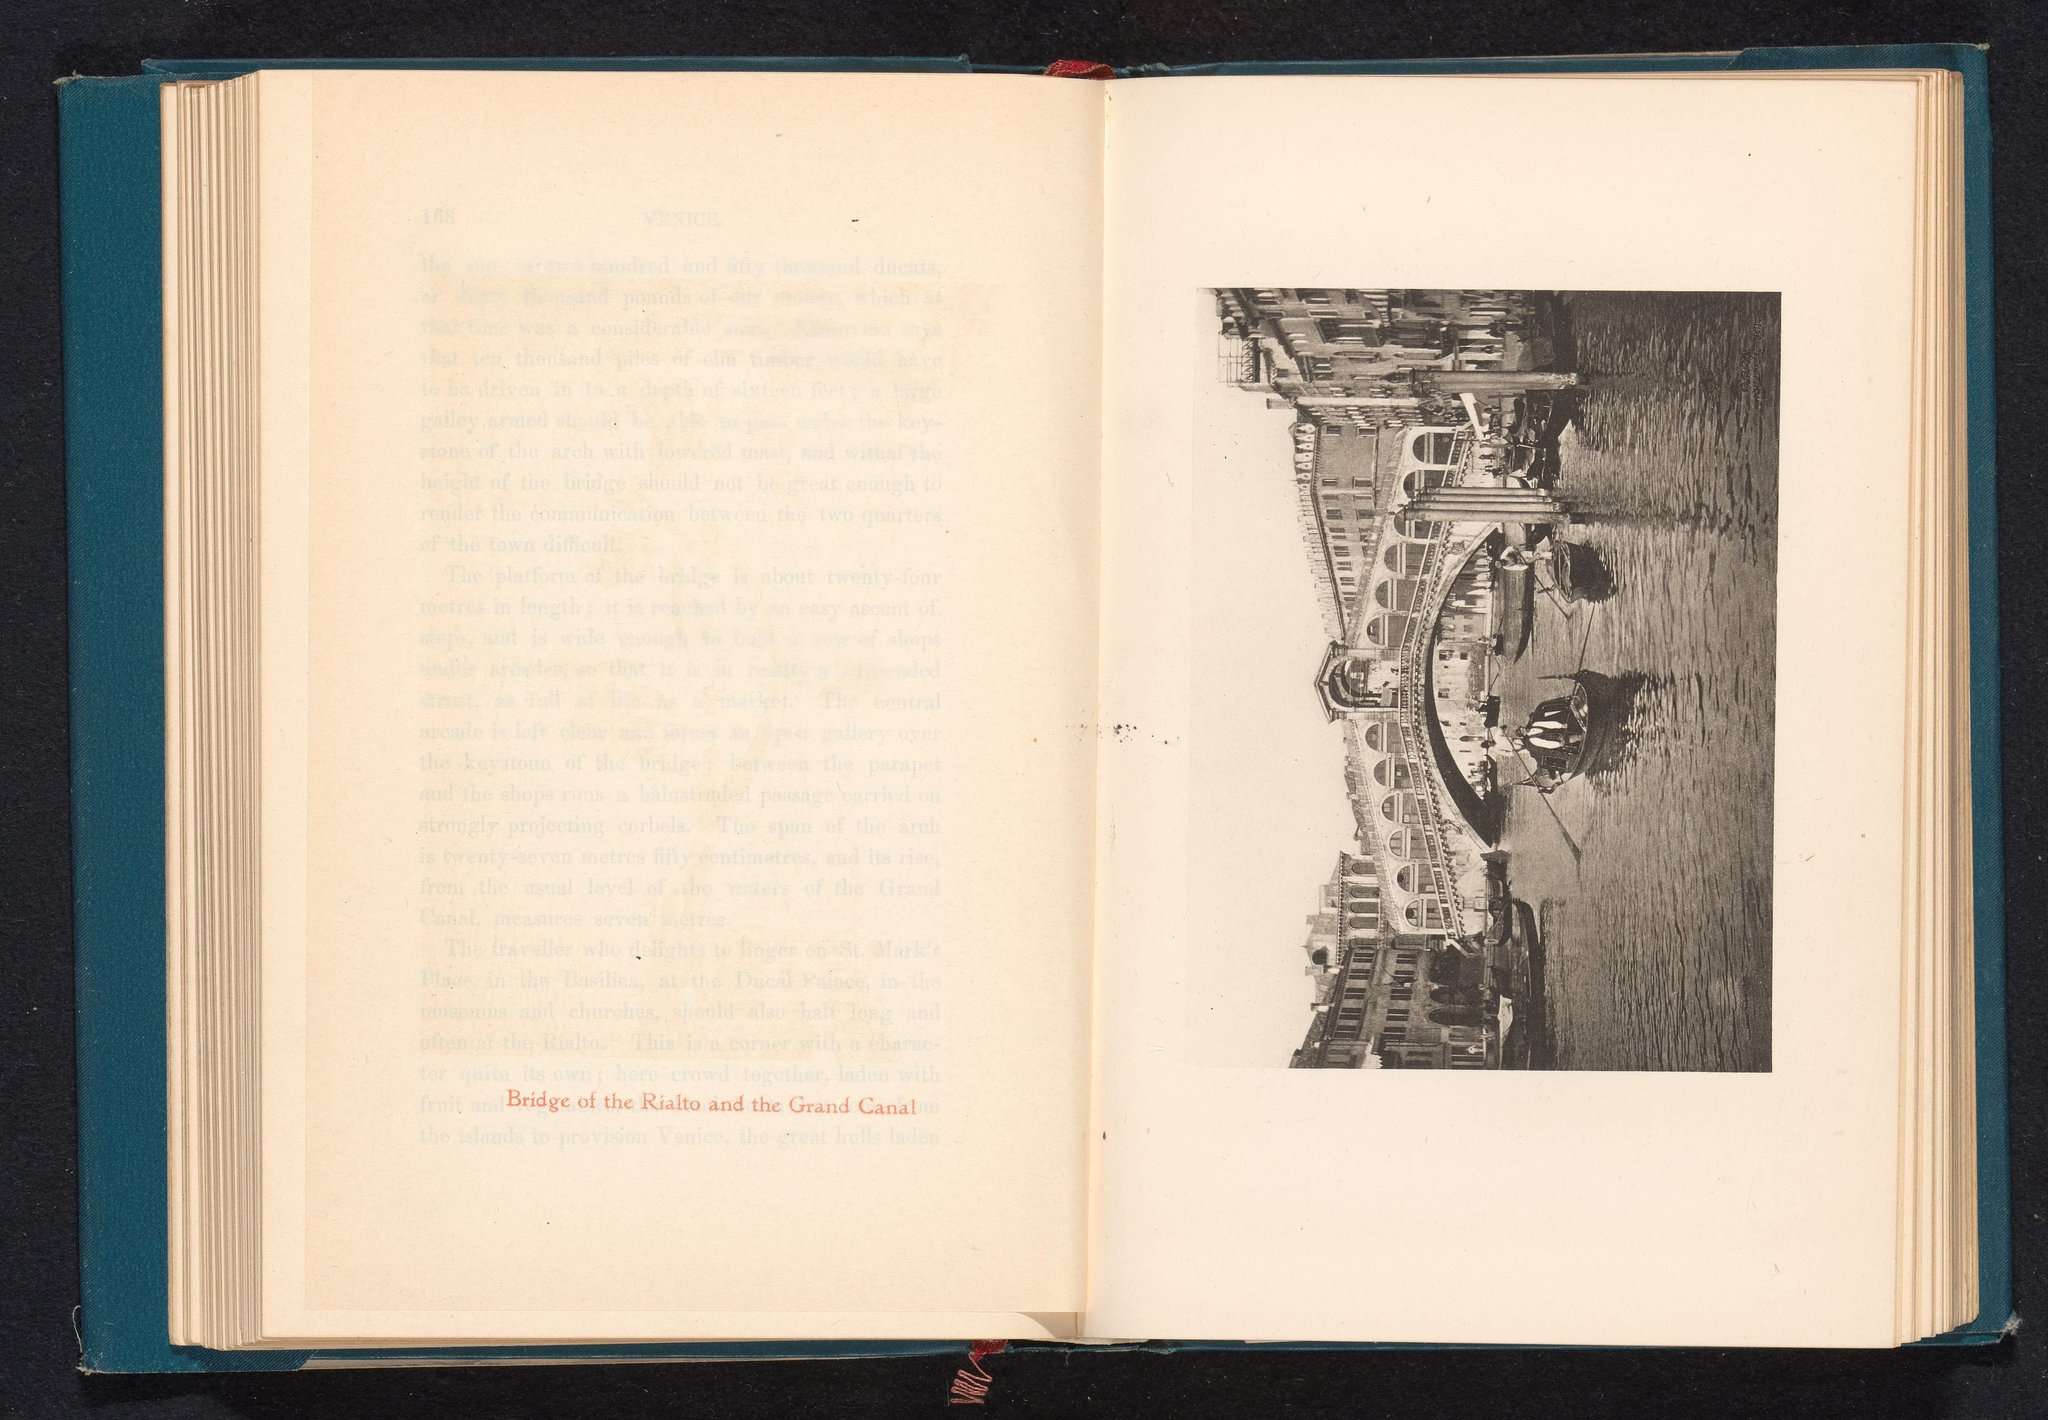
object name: photomechanical print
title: Gezicht op de Rialtobrug te Venetië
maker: Anonymous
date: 1882-1892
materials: paper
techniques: photoaquatint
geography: boston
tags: canals, waters (in city), bridge in city across river, canal, etc.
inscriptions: title: ‘Bridge of the Rialto and the Grand Canal’